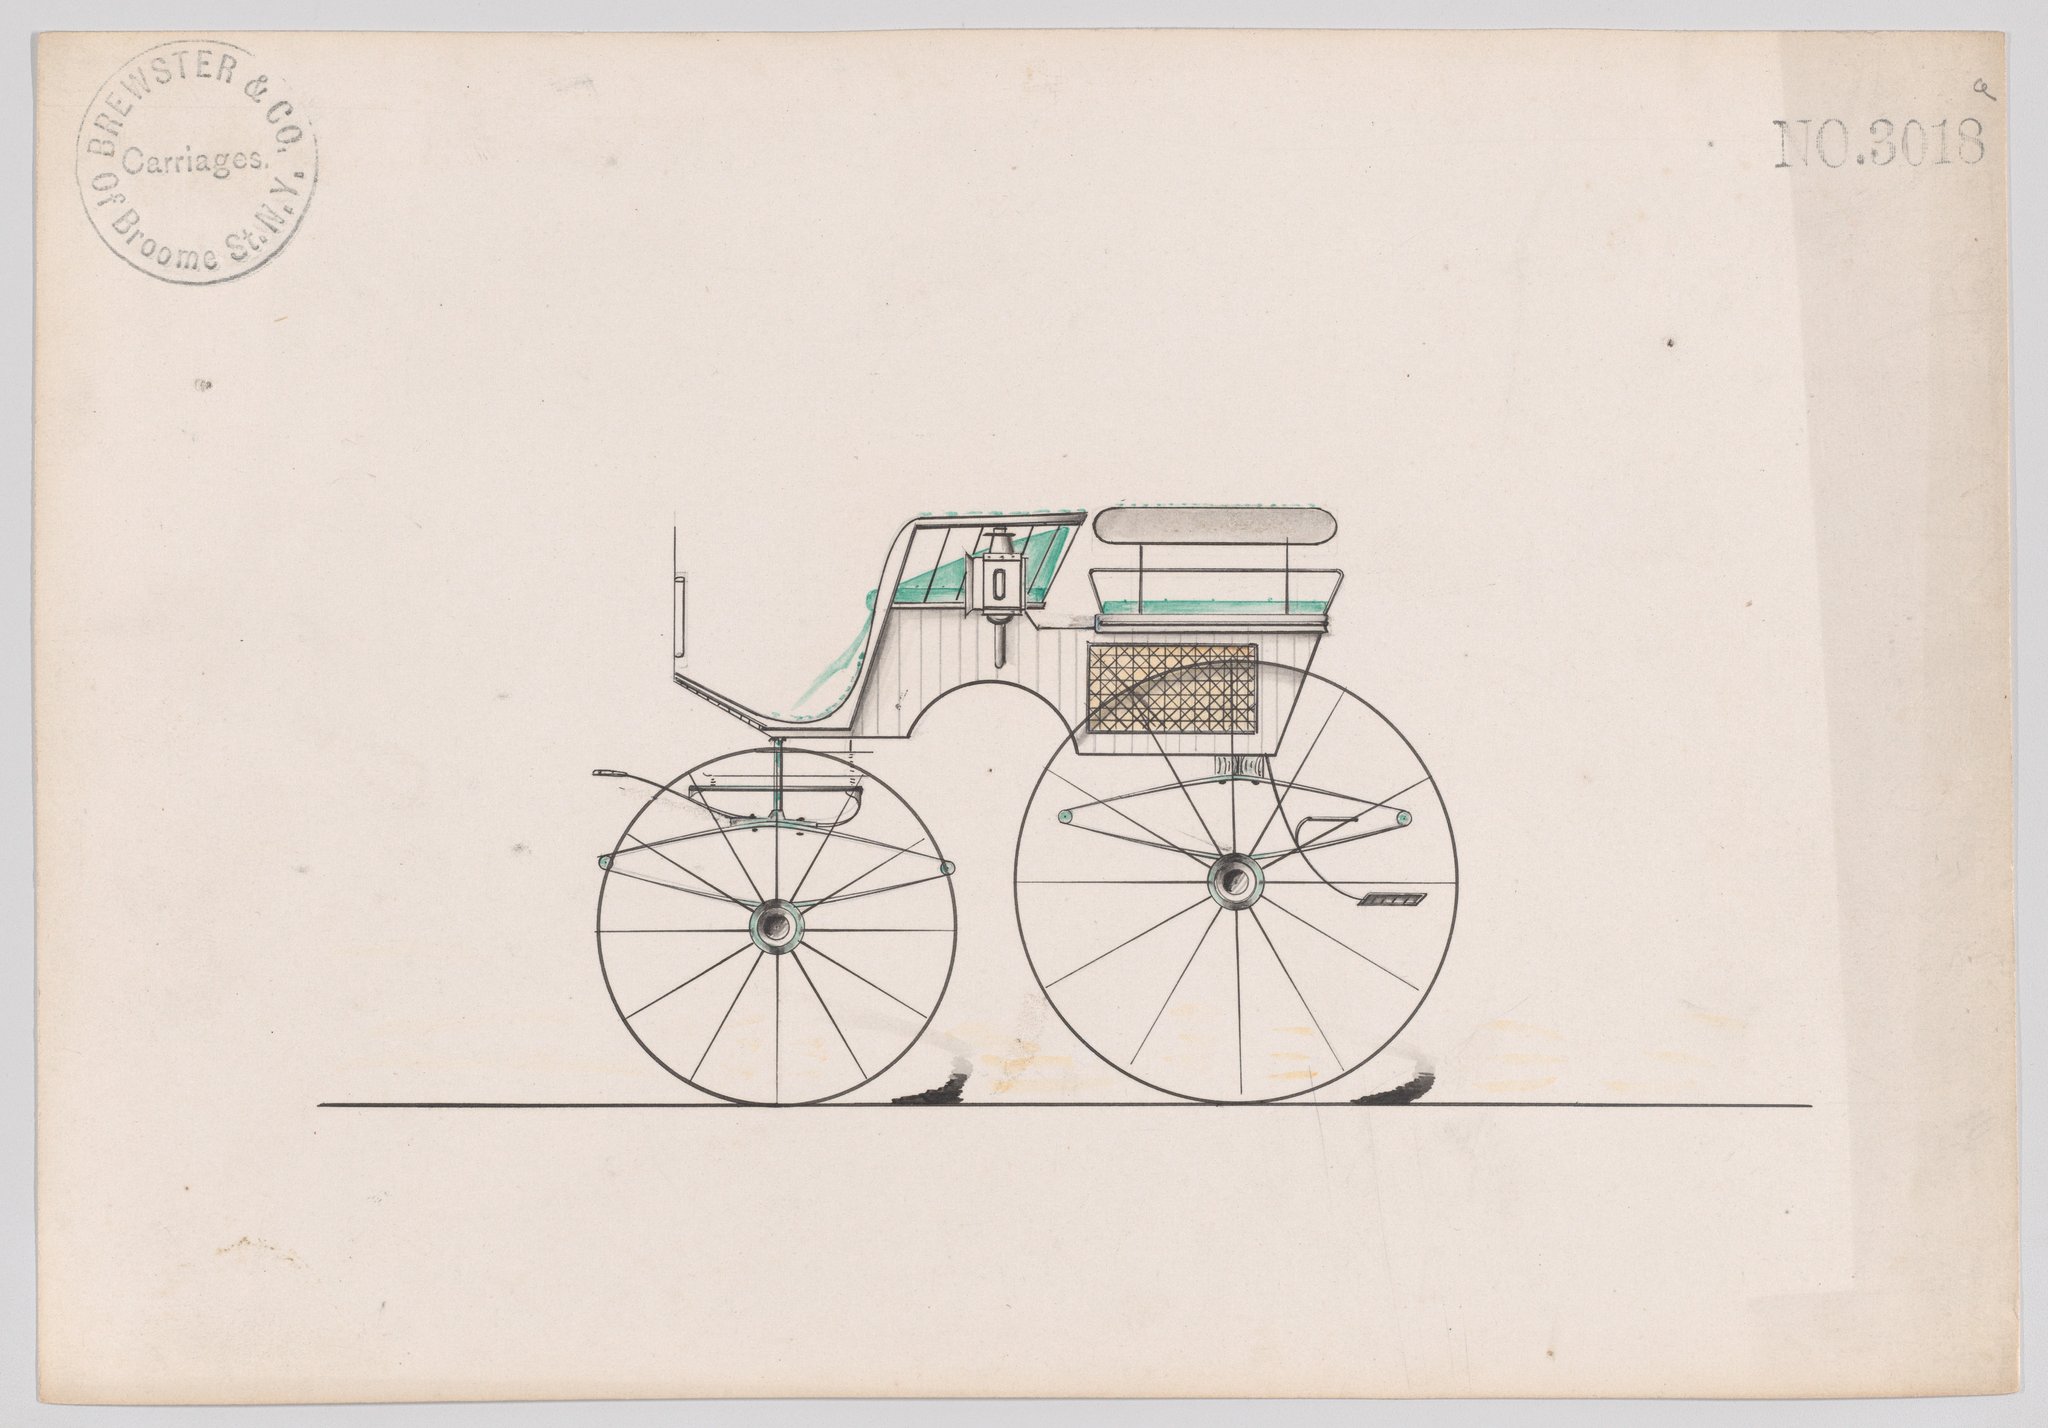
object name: drawing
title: Design for Dog Cart or 2 Wheeler, no. 3018a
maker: brewster & co.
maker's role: manufacturer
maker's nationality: american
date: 1874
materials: gouache, ink, watercolor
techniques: pen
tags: carriages